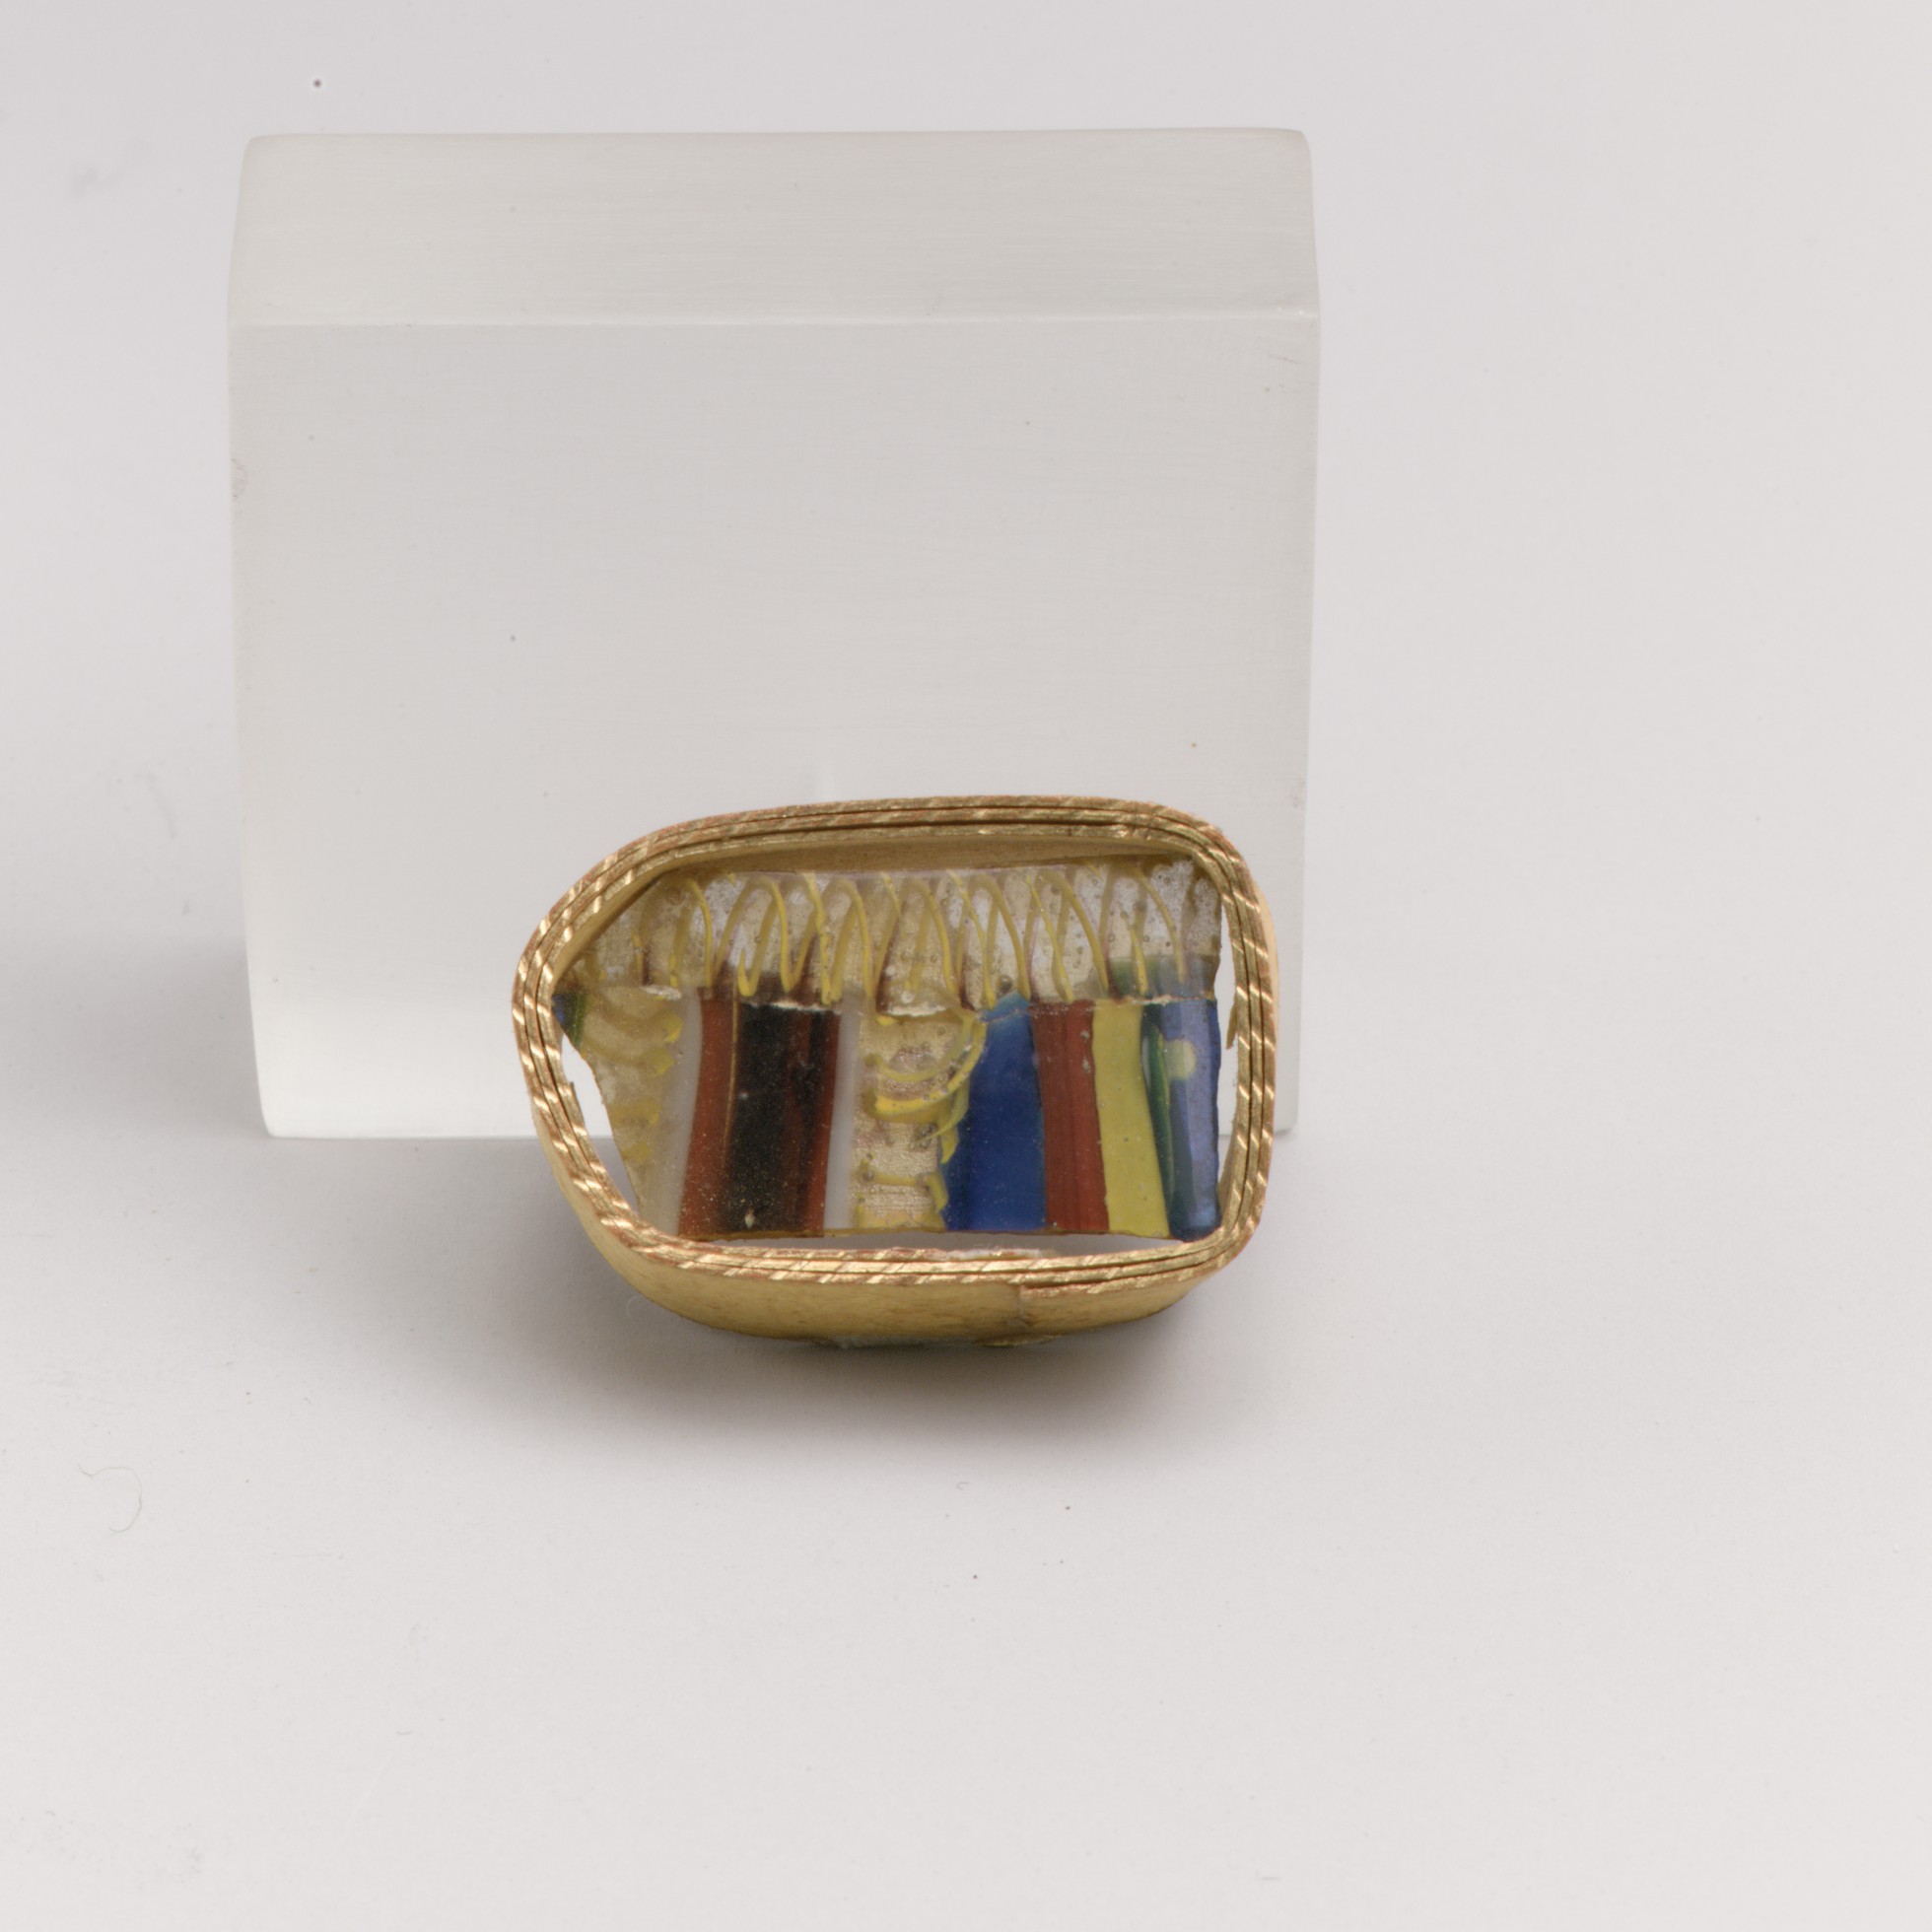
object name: fragment, striped mosaic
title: Glass striped mosaic fragment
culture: roman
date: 34 BCE-33 CE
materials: glass